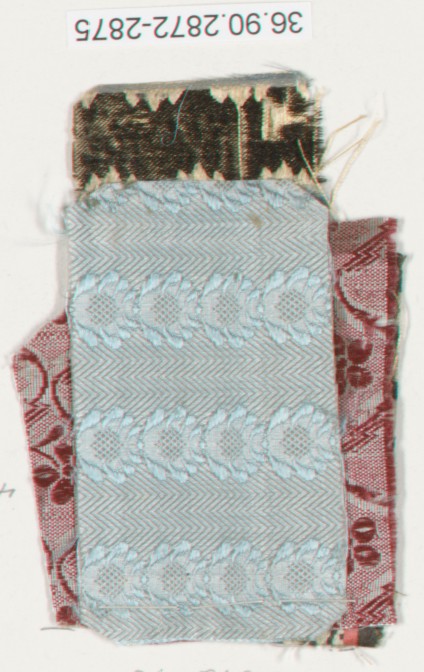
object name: piece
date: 1801-1900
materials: silk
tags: flowers